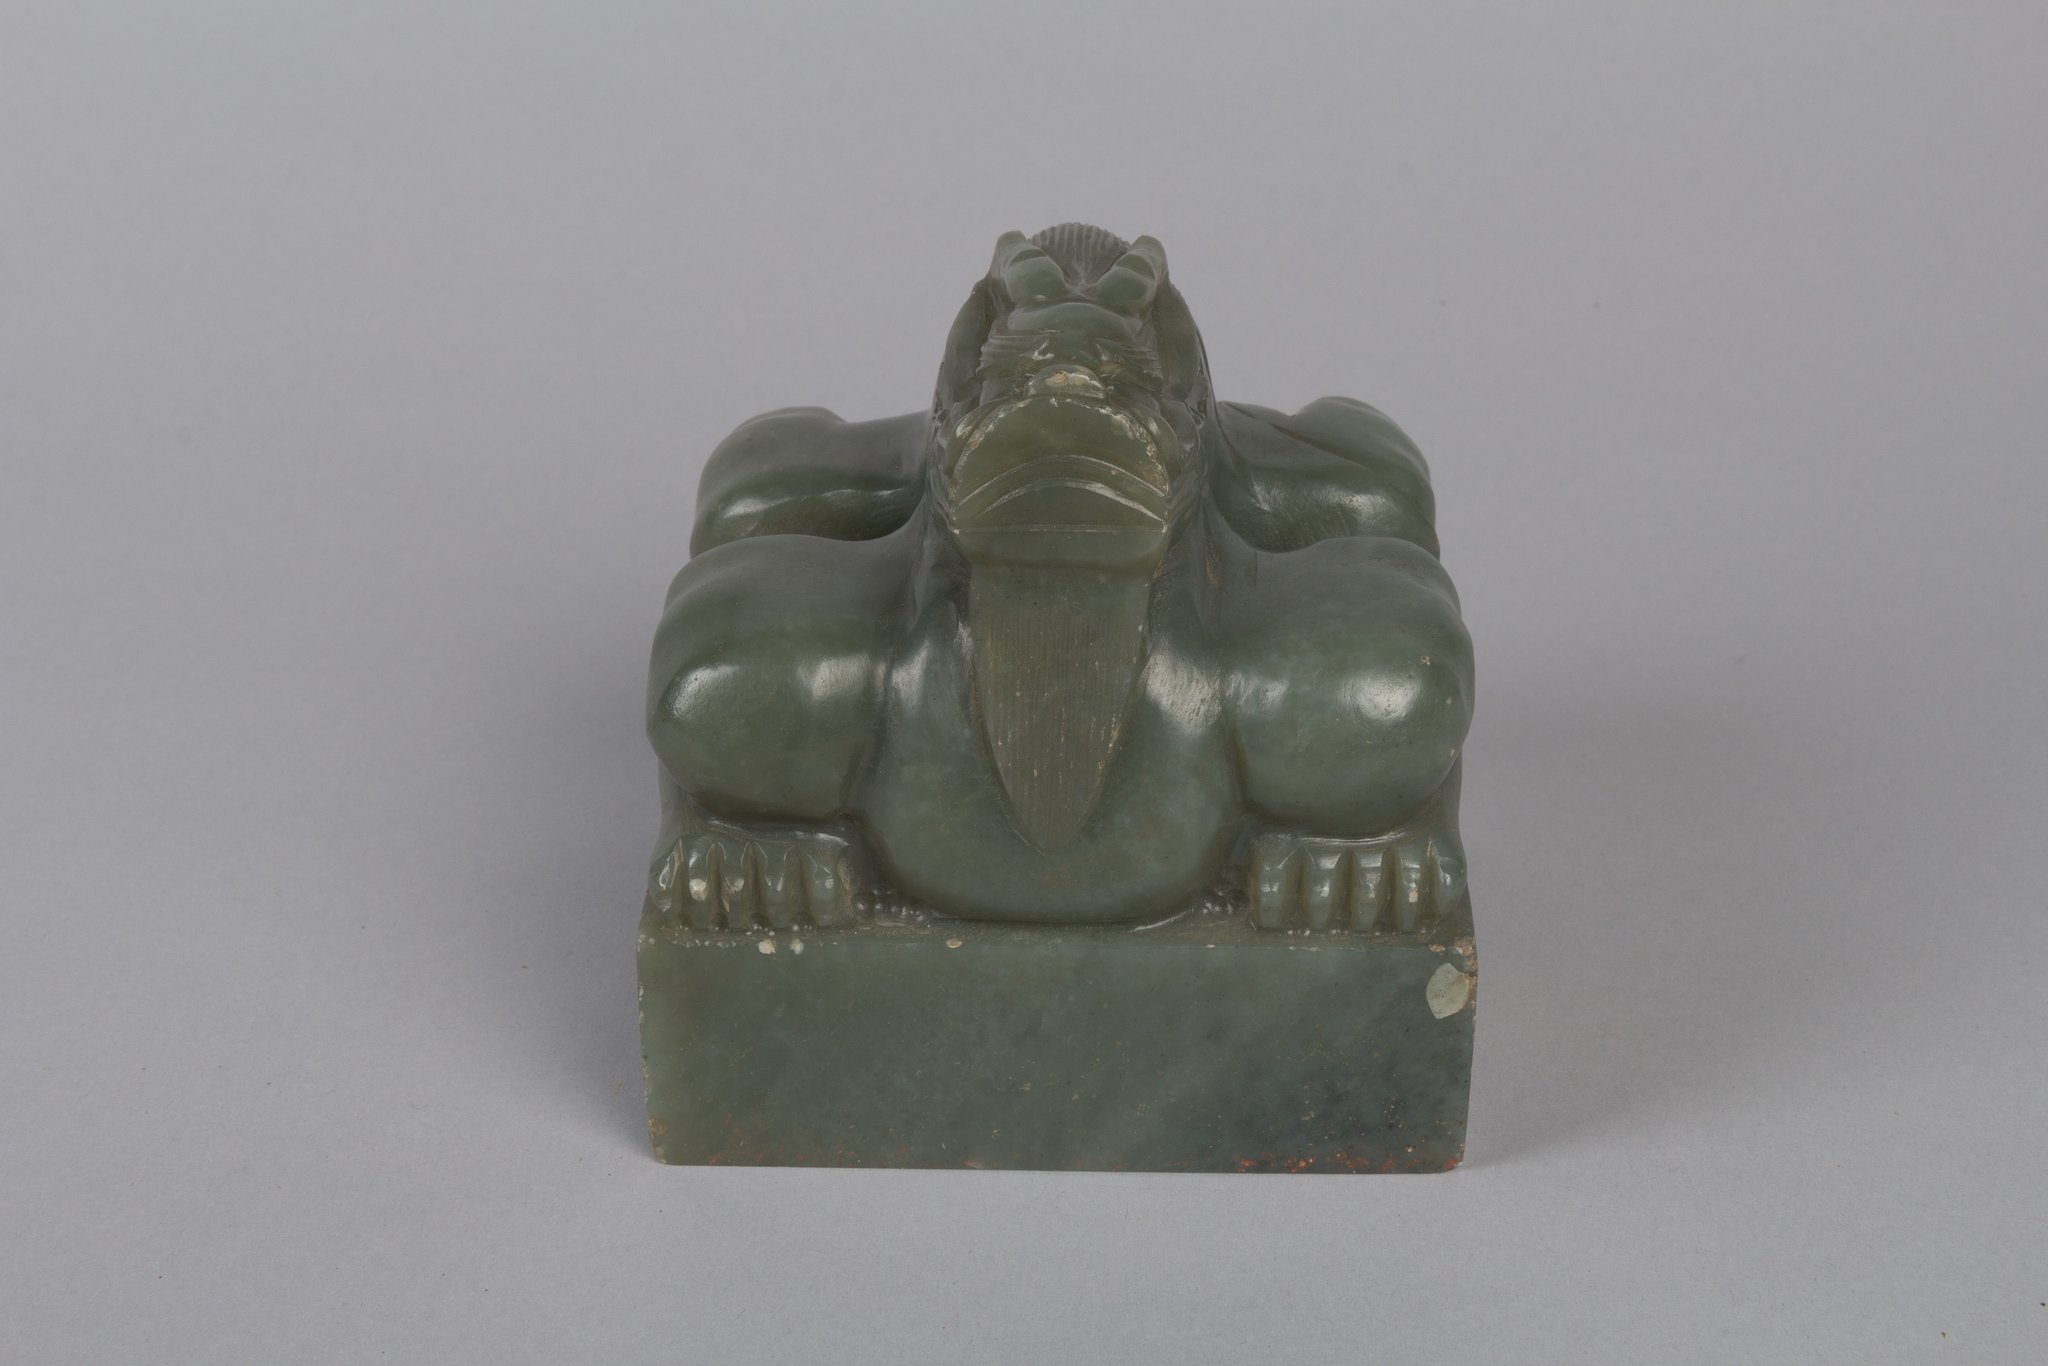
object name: seal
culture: chinese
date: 1901-1933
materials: jade